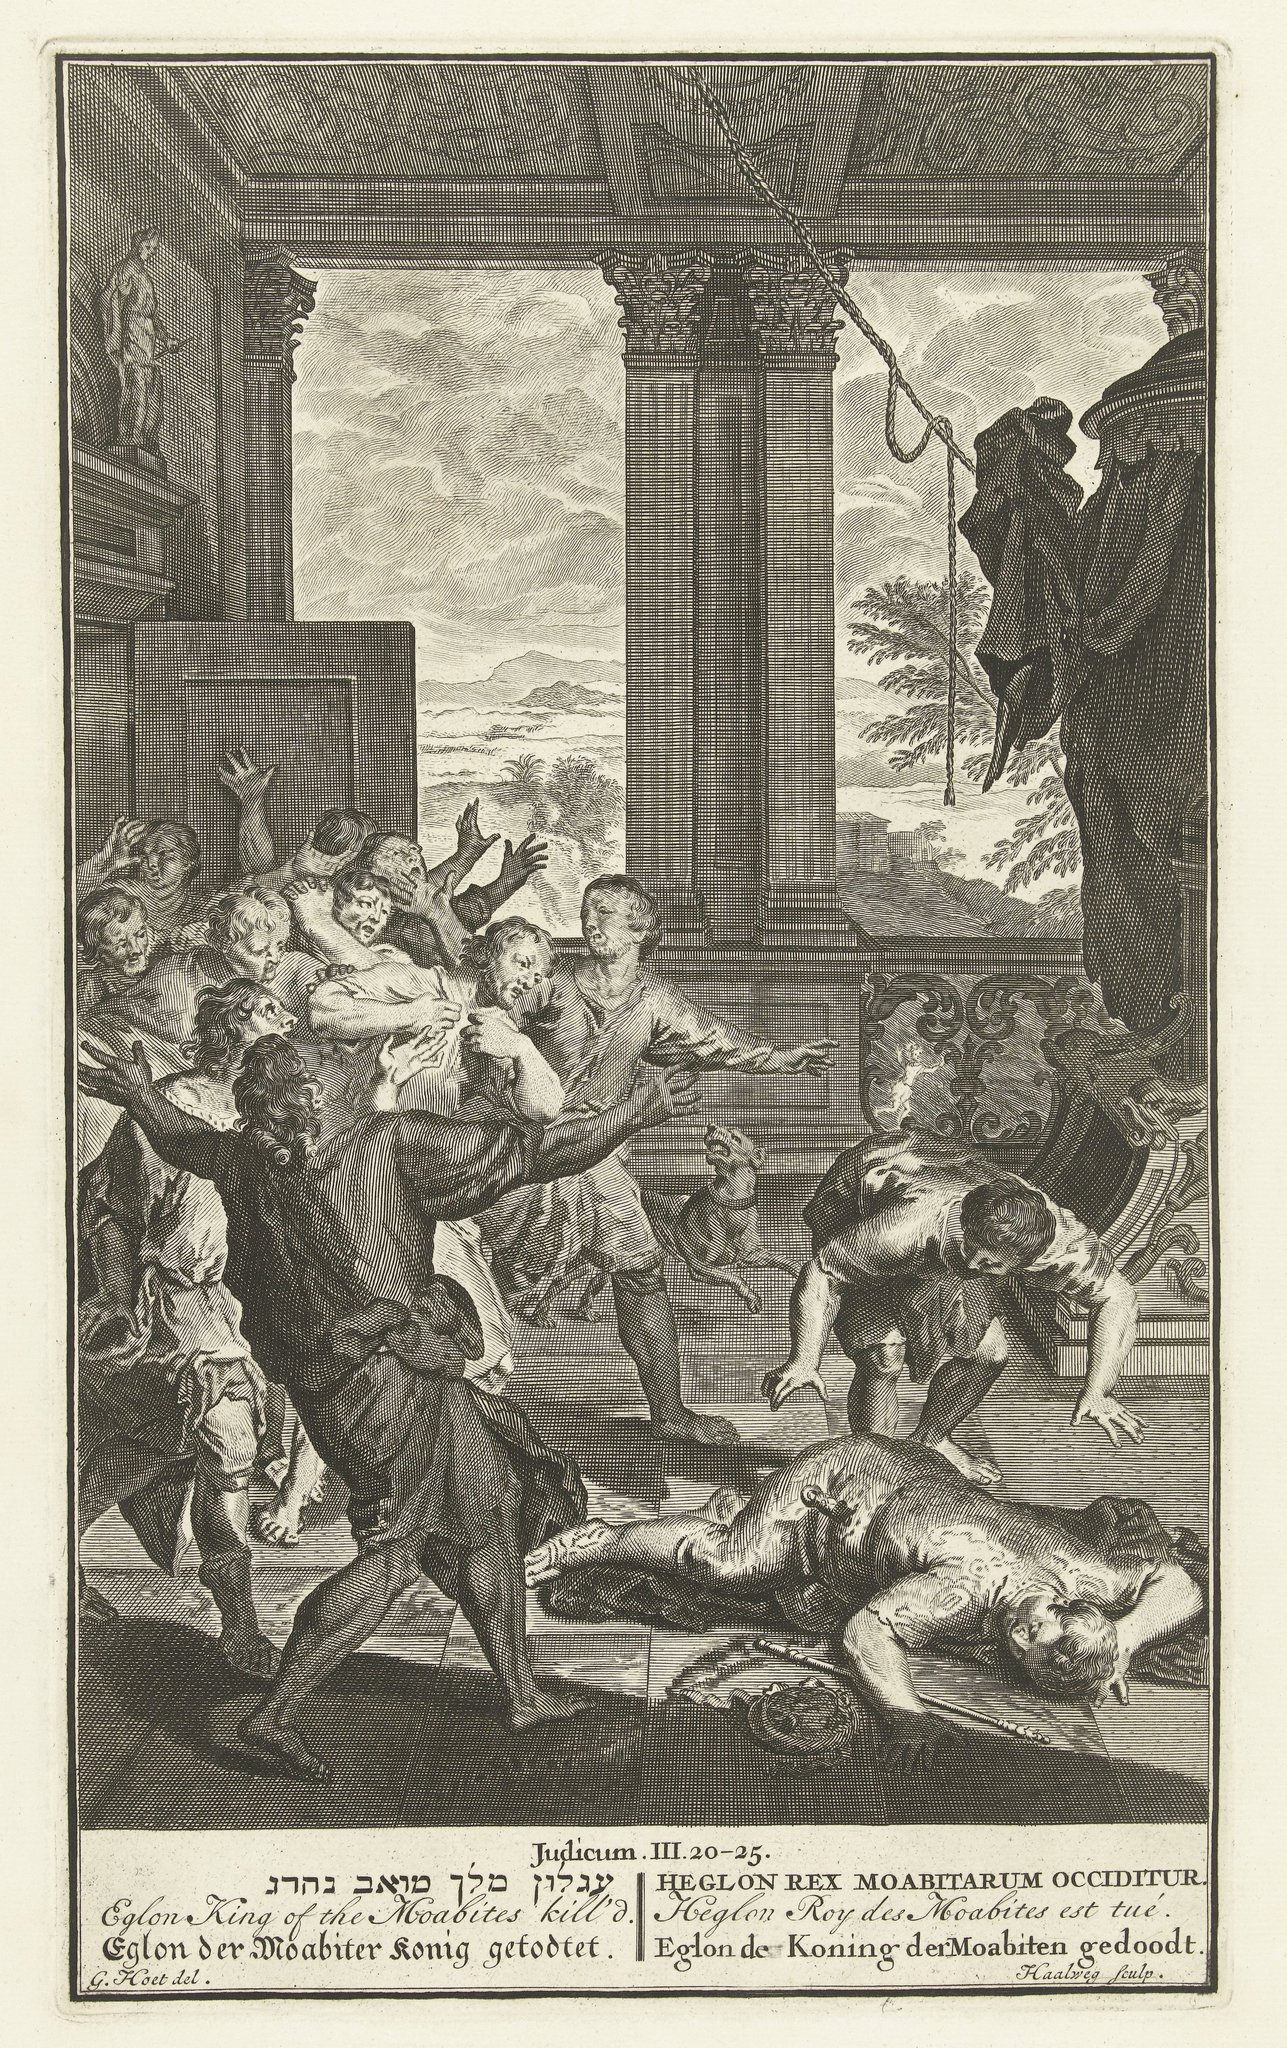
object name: book illustration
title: Eglon, de Koning der Moabiten wordt dood gevonden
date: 1664-1696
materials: paper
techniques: engraving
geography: northern netherlands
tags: eglon is found dead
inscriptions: collector's mark: Lugt 2228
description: In een interieur met klassieke zuilen en een doorkijk op een weids landschap ligt Eglon, koning van de Moabiten dood op de grond in een plas bloed, naast hem zijn staf en hoofddeksel. Een aantal mannen komt door een deur links, hun handen vertwijfeld naar boven geheven. Onder de voorstelling de naam van het evangelie en de verzen, daaronder de titel van de voorstelling in zes talen.